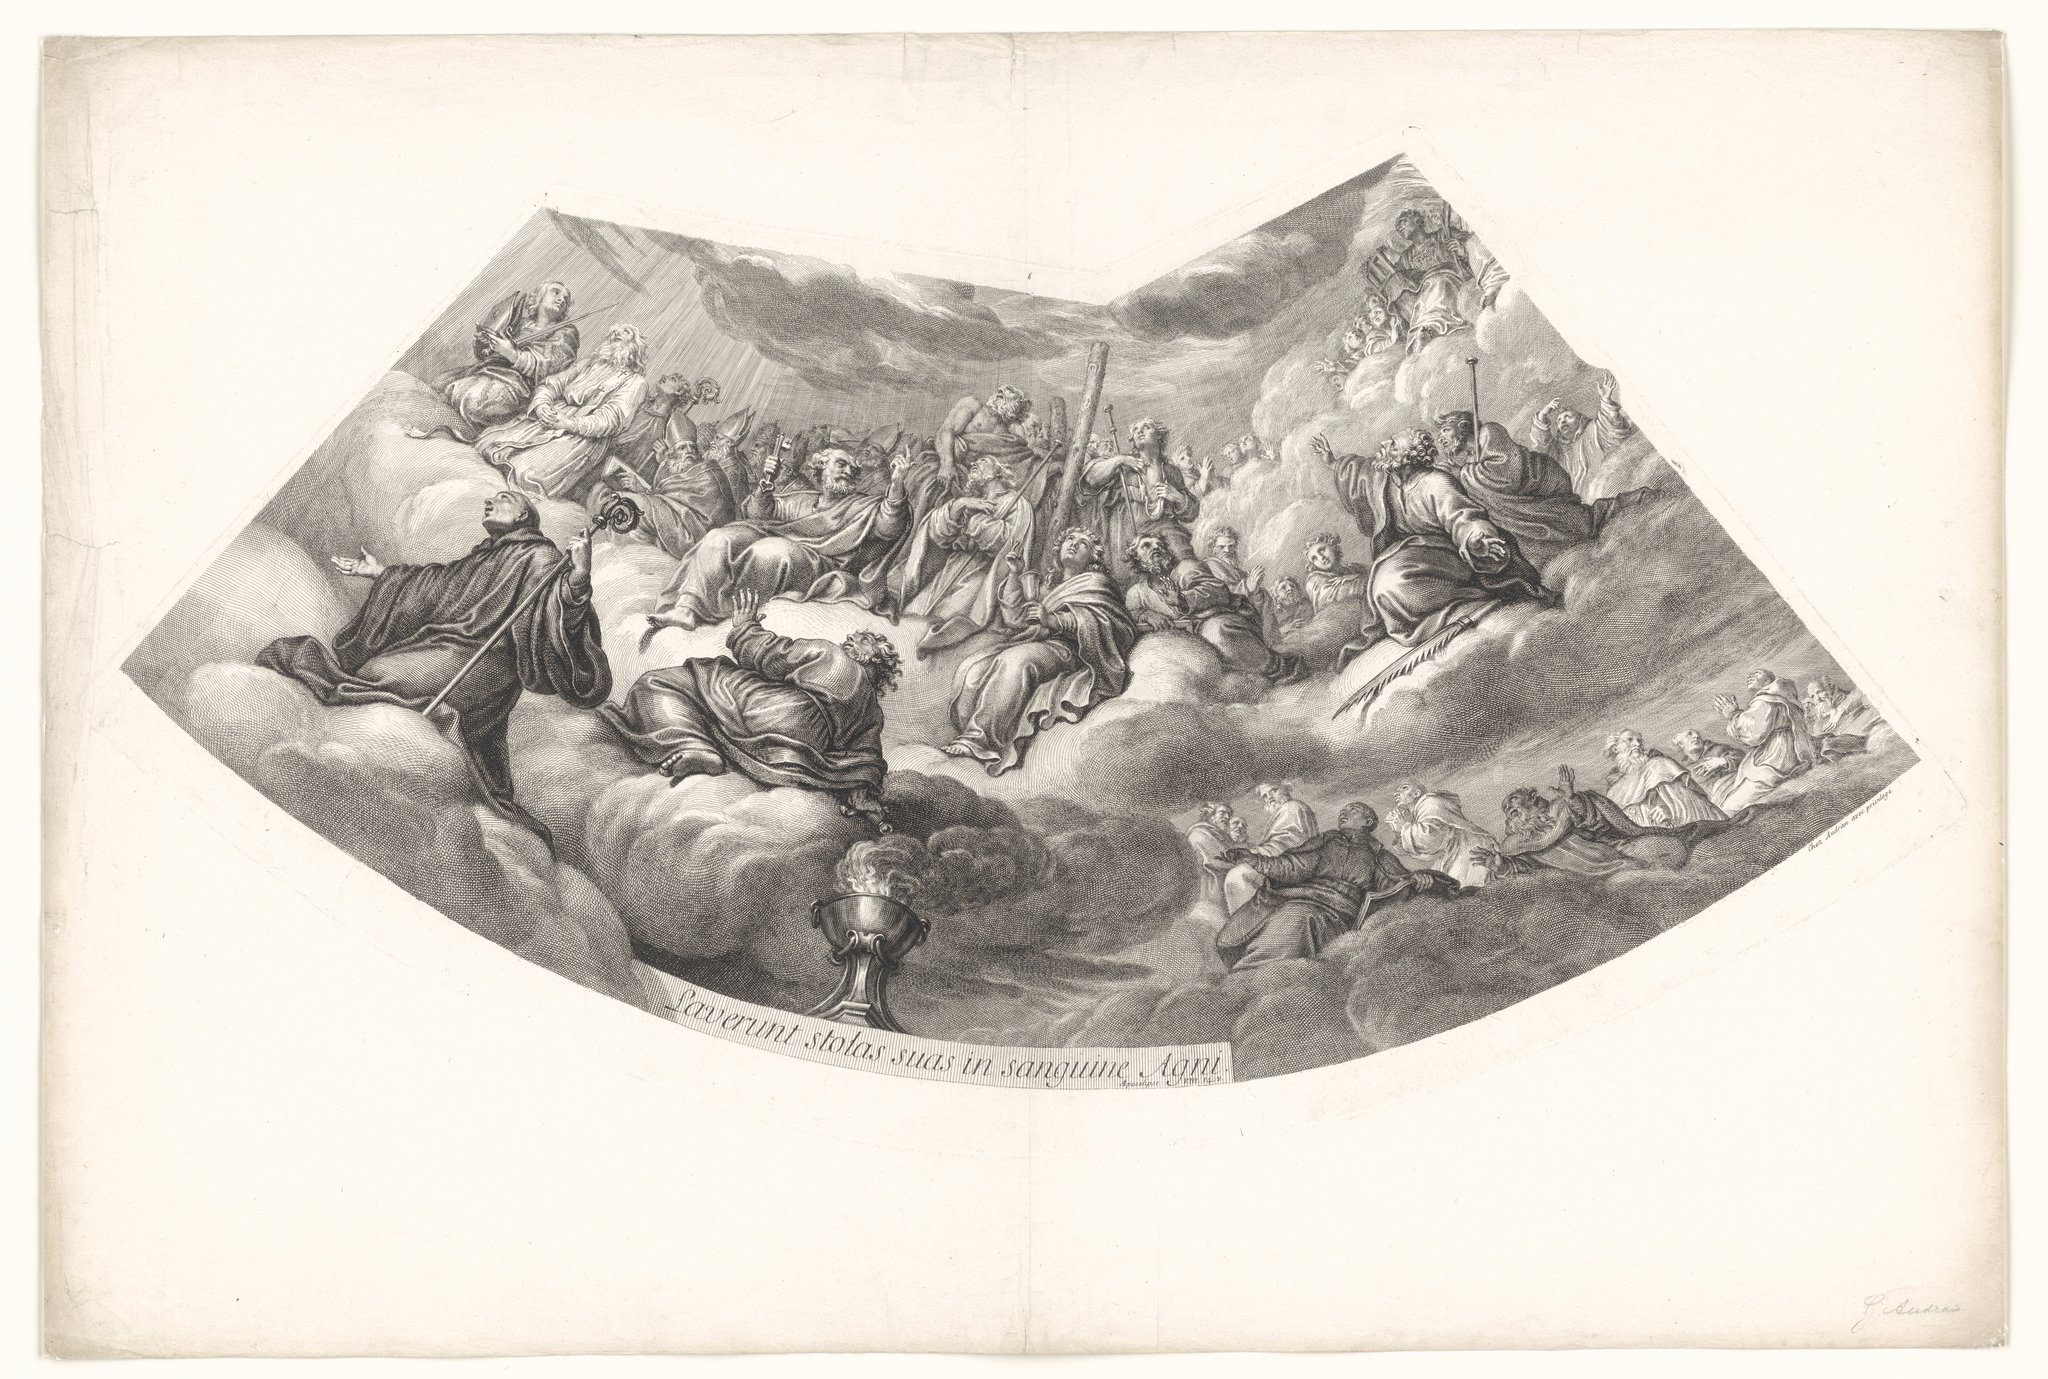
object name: print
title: Plafondschilderingen in de koepel van de kerk Val-du-Grace: o.a. Petrus en Johannes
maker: gérard audran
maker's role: print maker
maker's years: 1640-1703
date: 1650-1703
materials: paper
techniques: engraving, etching